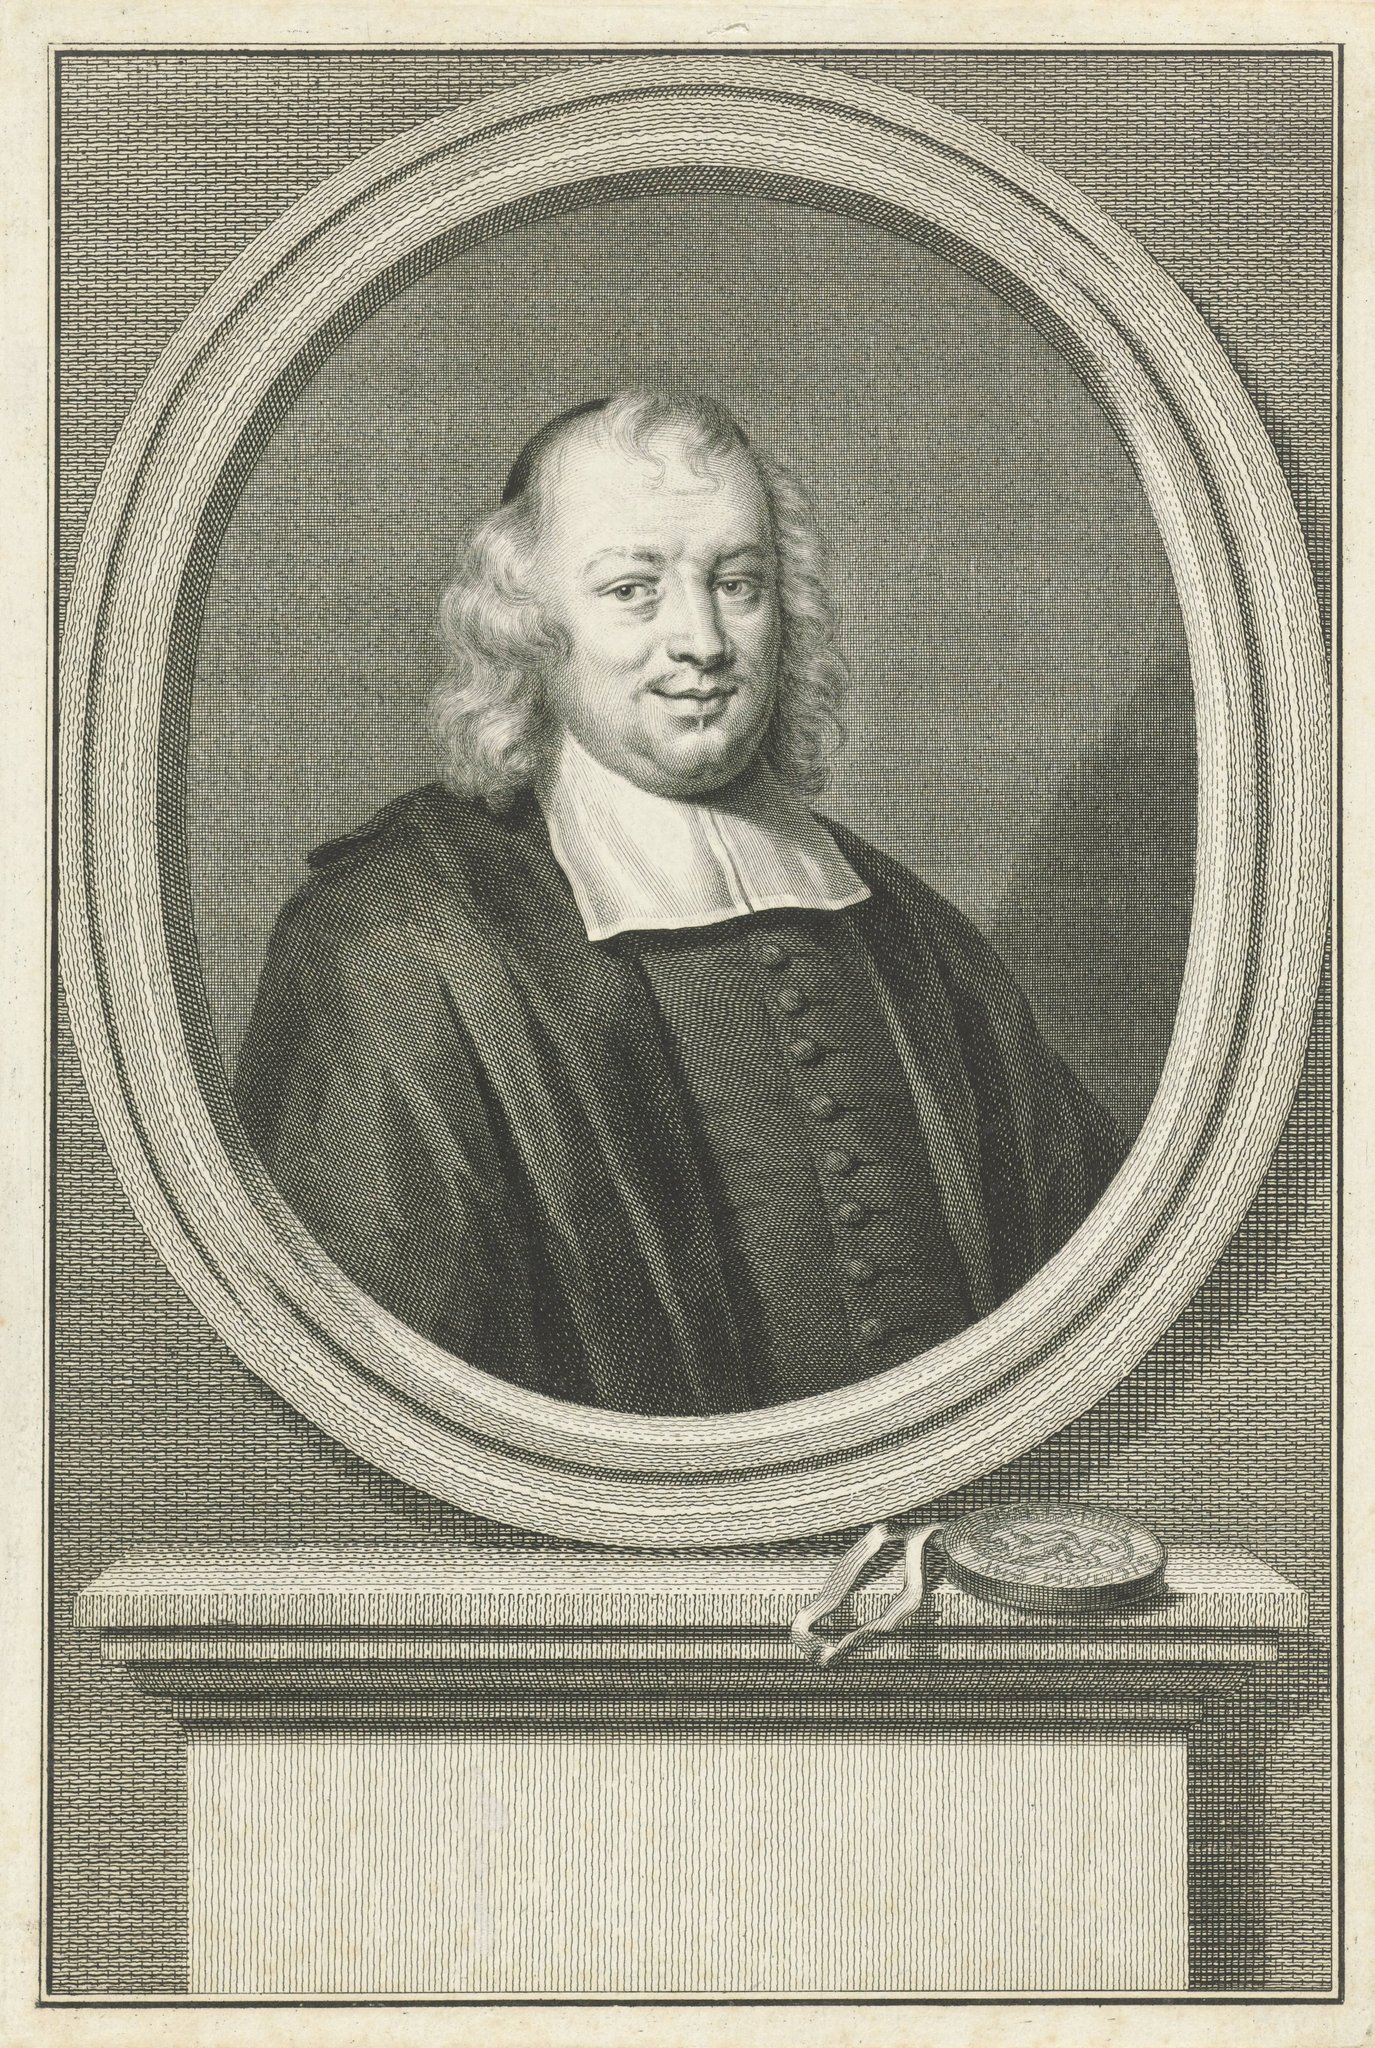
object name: print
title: Portret van Gaspar Fagel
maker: jacob houbraken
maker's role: draughtsman, print maker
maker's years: 1698-1780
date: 1708-1780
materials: paper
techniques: engraving, etching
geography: amsterdam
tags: gaspar fagel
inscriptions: collector's mark: Lugt 2228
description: Portret naar rechts van Gaspar Fagel in een ovaal. Het portret rust op een piedestal waarop een zegel ligt met de afbeelding van de Hollandse Leeuw.